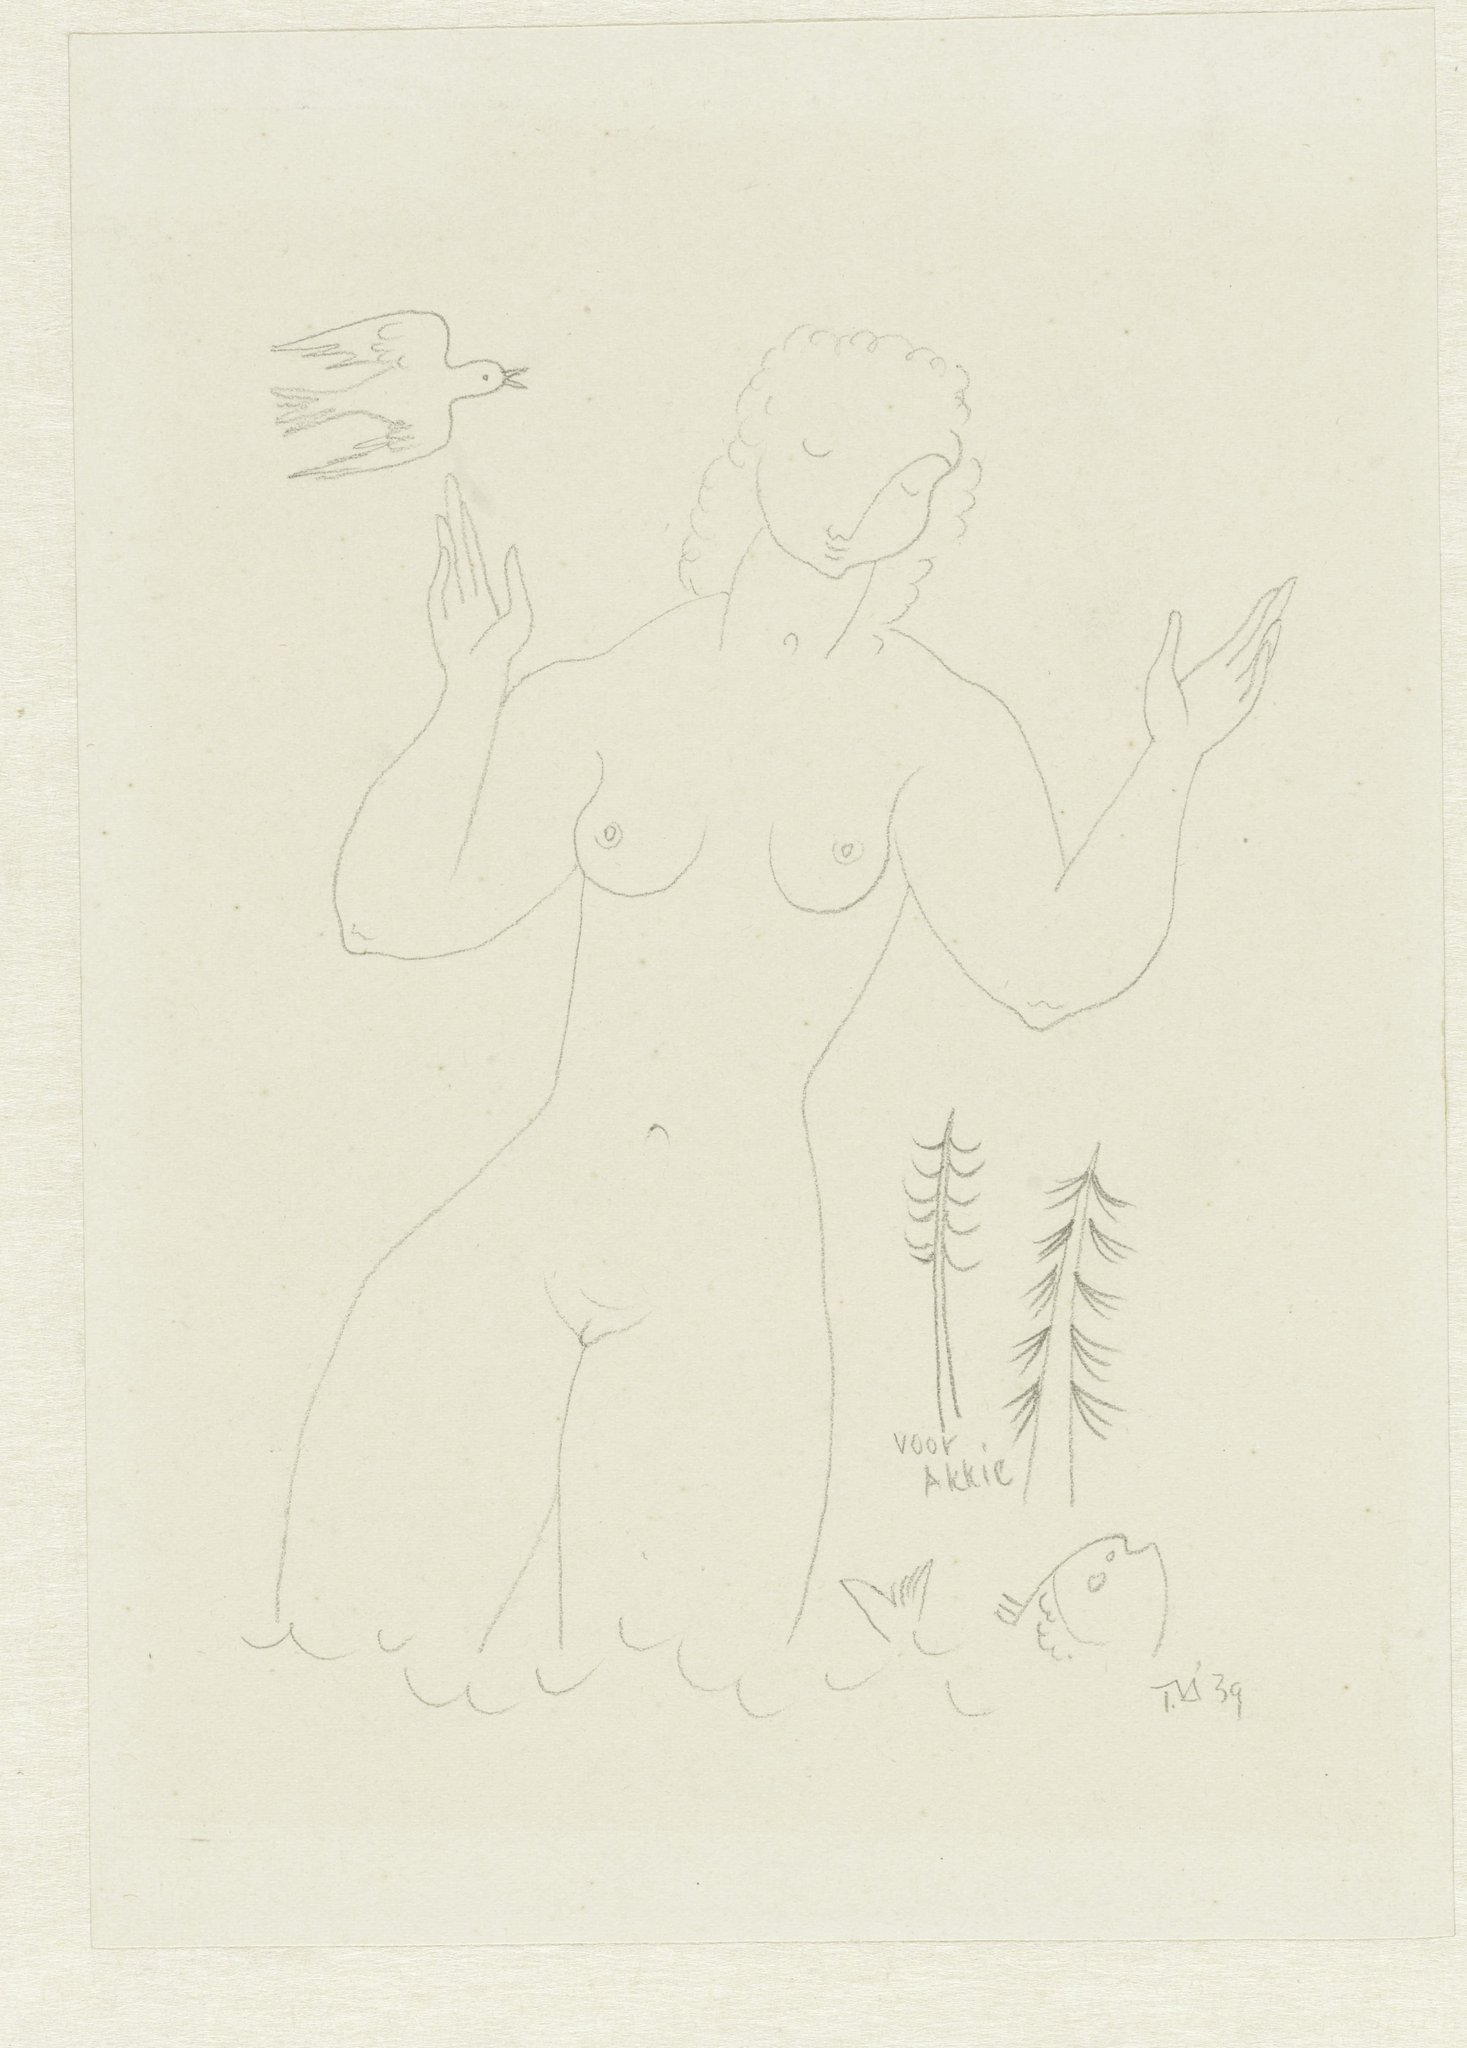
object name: drawing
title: Badende vrouw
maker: tinus van doorn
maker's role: painter, print maker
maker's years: 1905-1940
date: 1939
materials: paper, pencil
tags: washing and bathing - aa - in the open air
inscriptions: inscription: ‘7’, collector's mark: Lugt 2228, stamp: ‘Rotterdam’, inscription: ‘voor Akkie’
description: Staande naakte vrouw met opgeheven armen in water met naast haar een vis. Achter haar staan twee bomen.